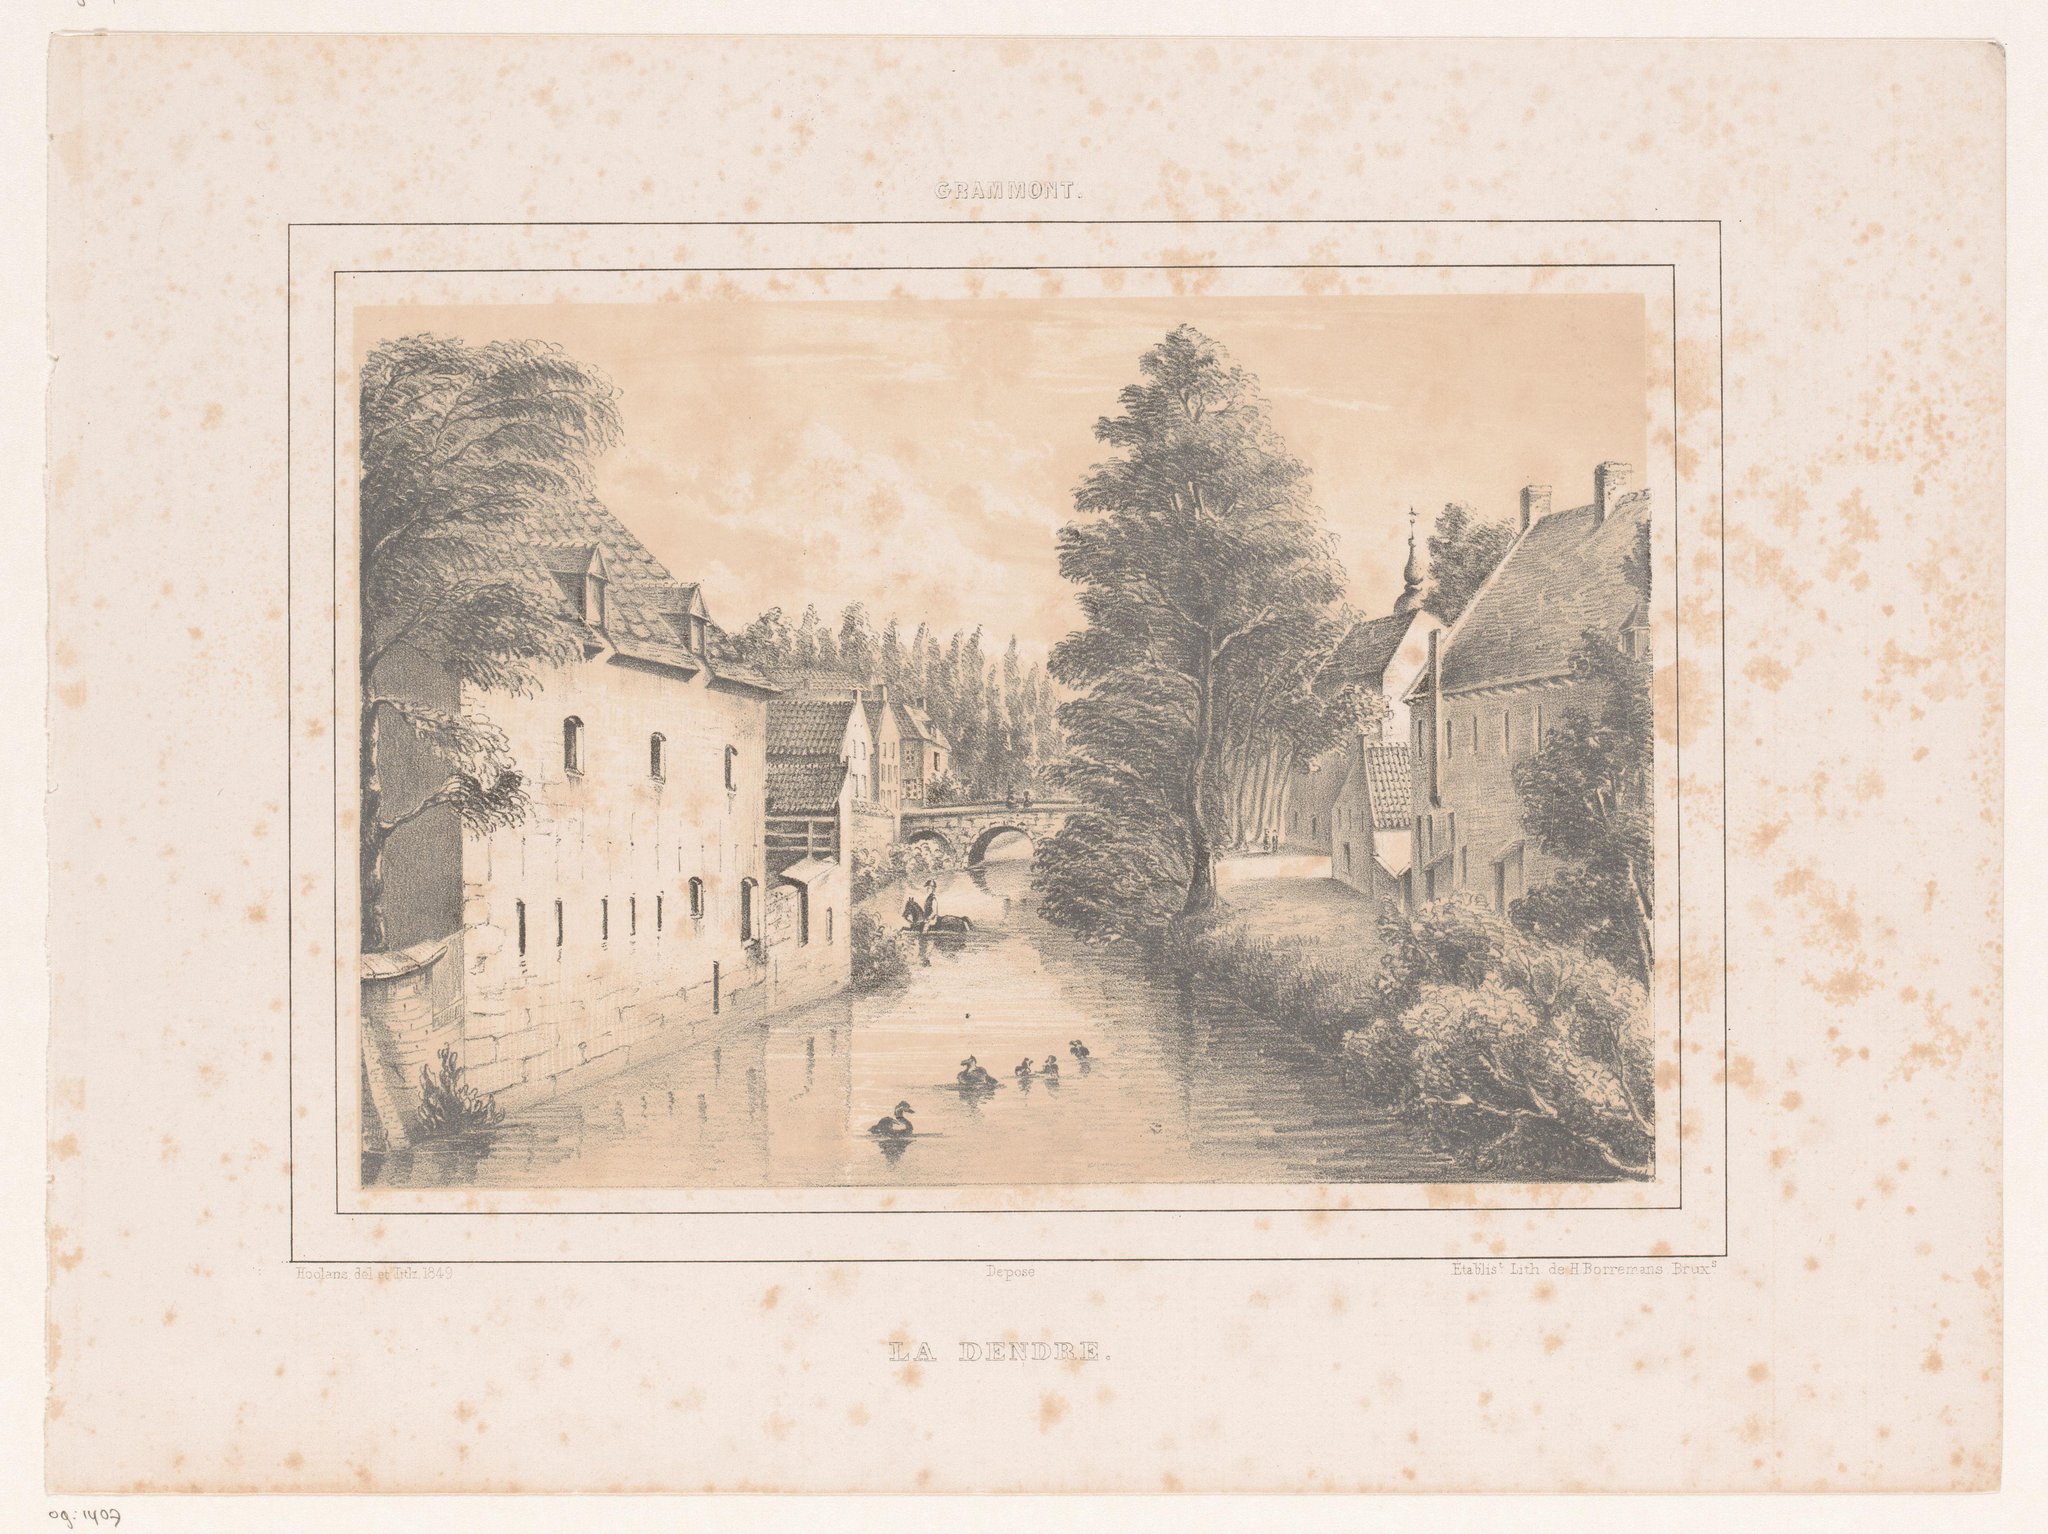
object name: print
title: Gezicht op rivier de Dender te Geraardsbergen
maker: joseph hoolans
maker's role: print maker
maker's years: 1814-1872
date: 1849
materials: paper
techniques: tone lithography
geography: brussels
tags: riding a horse, ass, or mule; rider, horseman, river, city-view in general; 'veduta' (+ city(-scape) with figures, staffage), bridge in village across river, canal, etc.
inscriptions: collector's mark: Lugt 2228, : ‘Déposé’